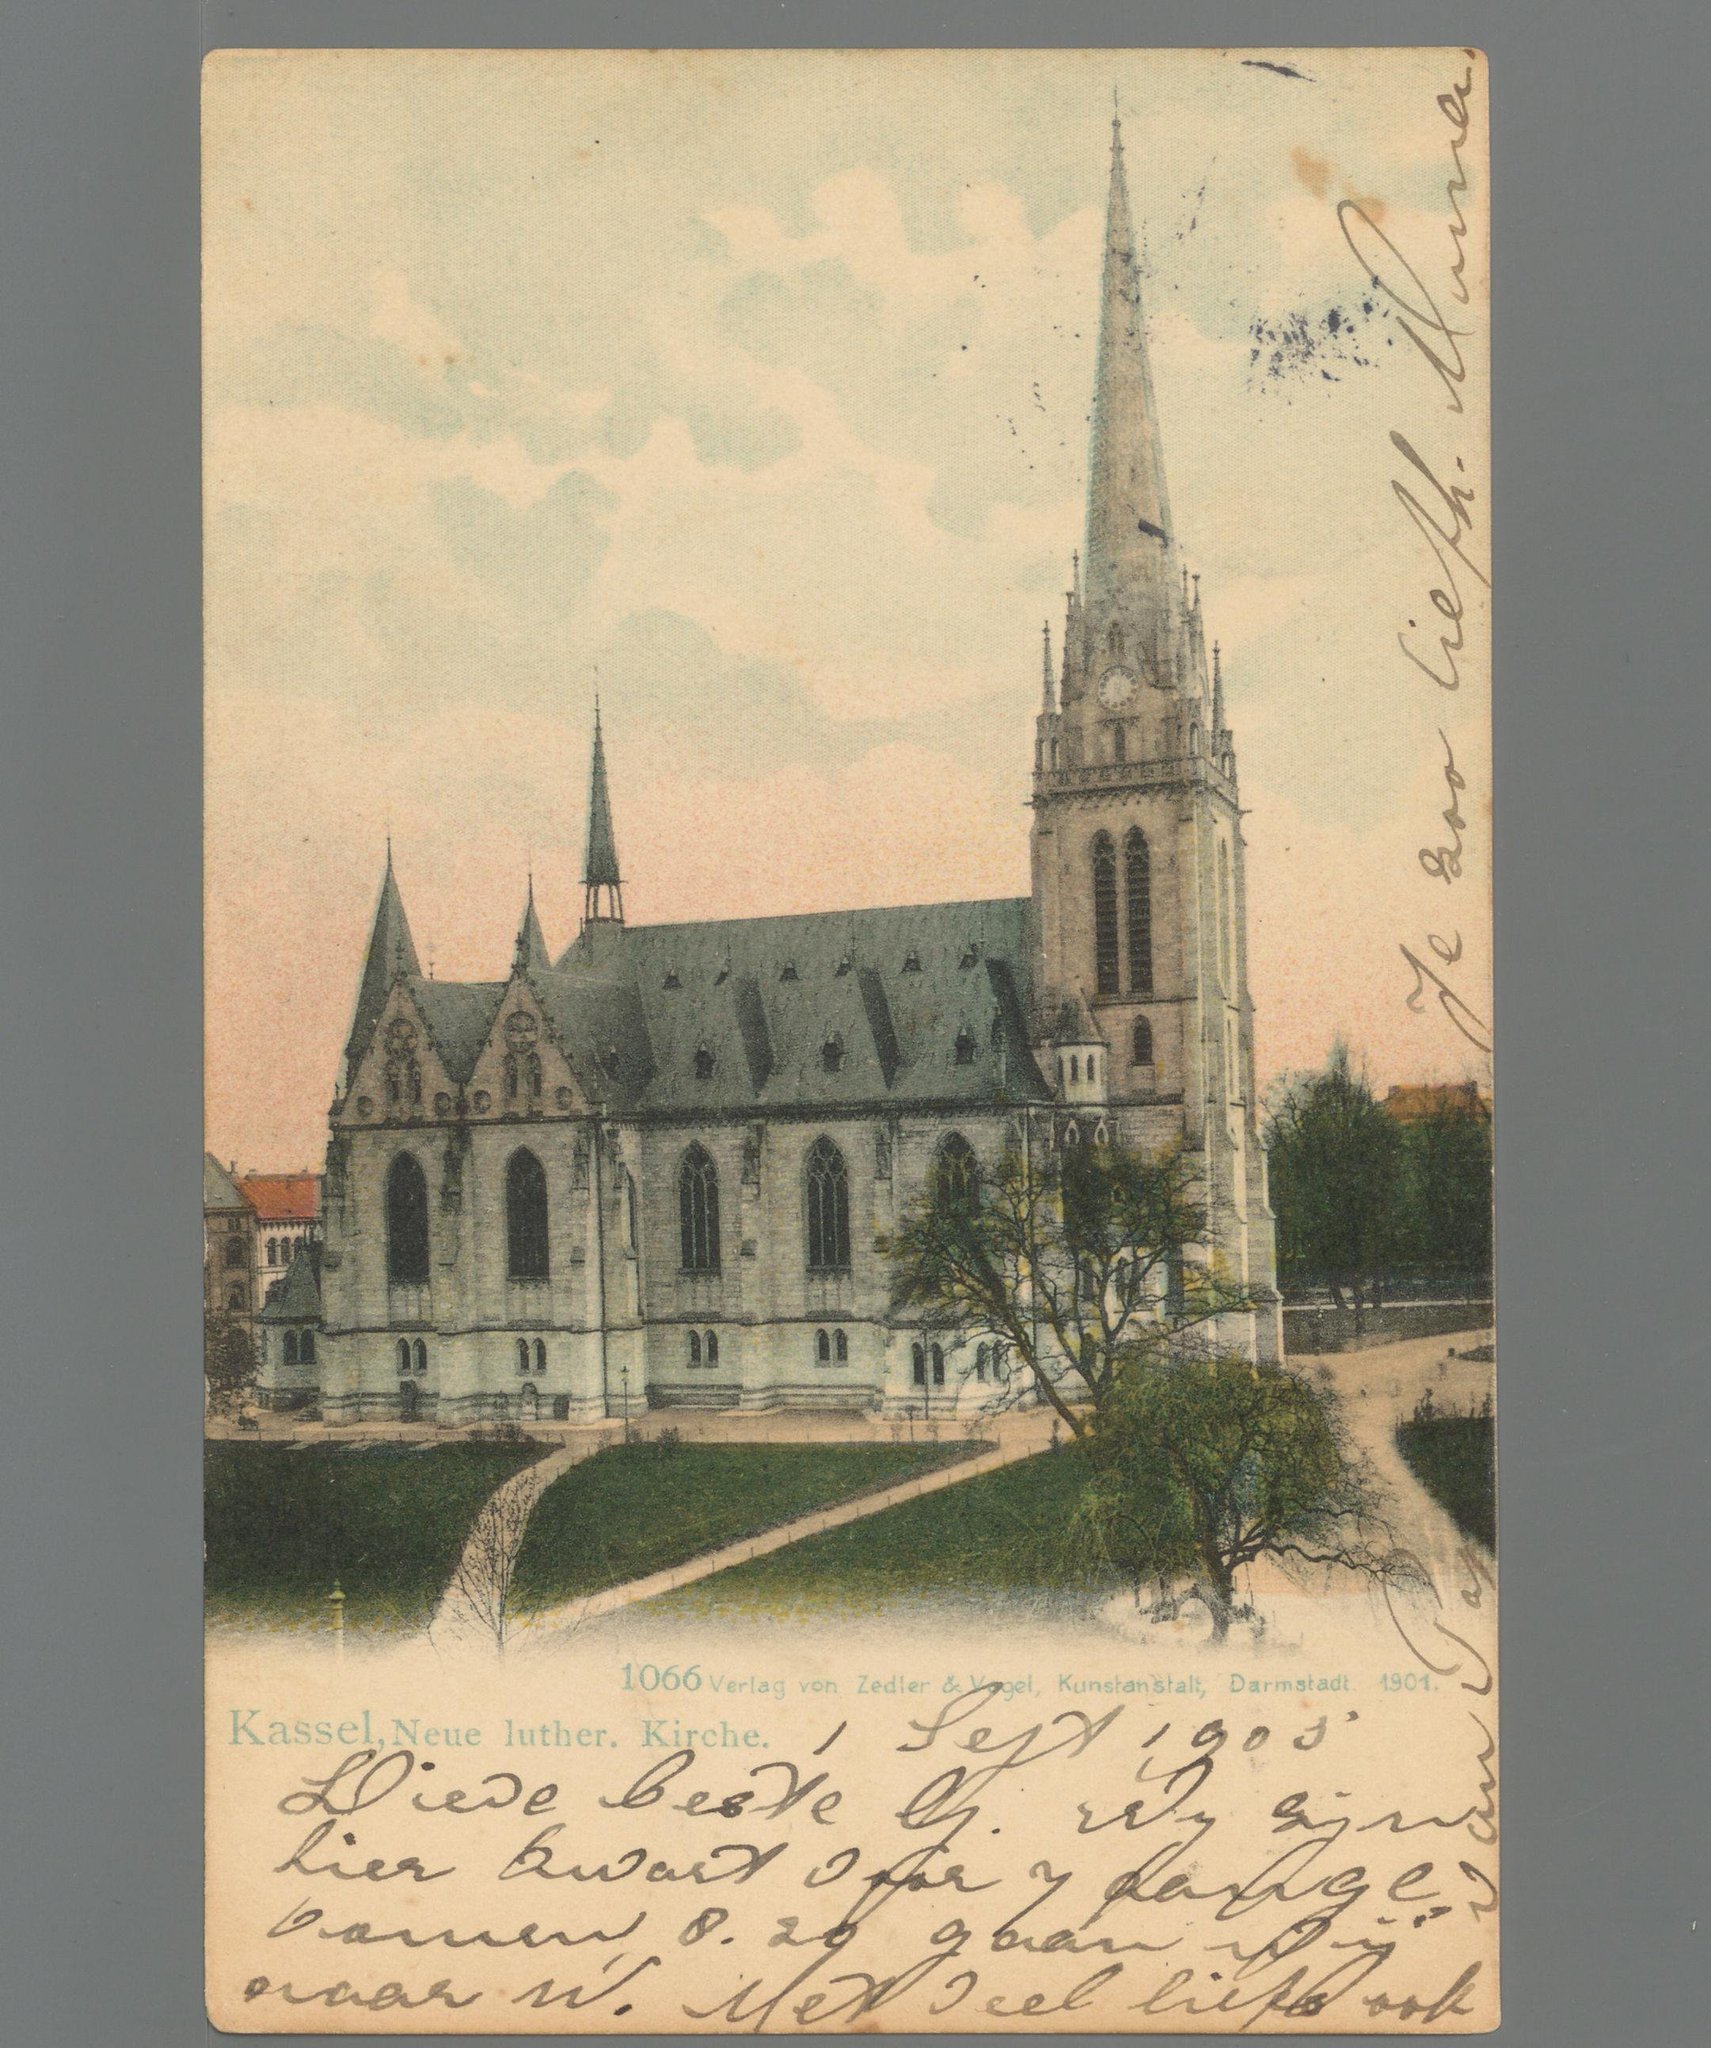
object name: photomechanical print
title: Kassel, Neue luther. Kirche.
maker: Anonymous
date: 1901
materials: cardboard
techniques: photograph, lithograph, writing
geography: darmstadt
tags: church (exterior)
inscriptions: postage stamp